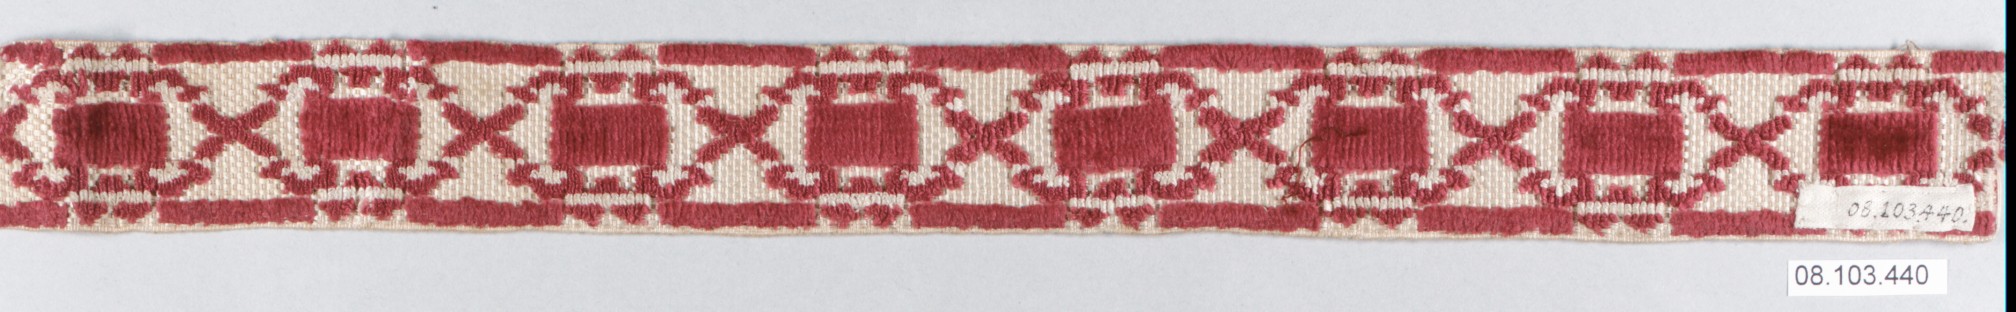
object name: galloon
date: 1701-1900